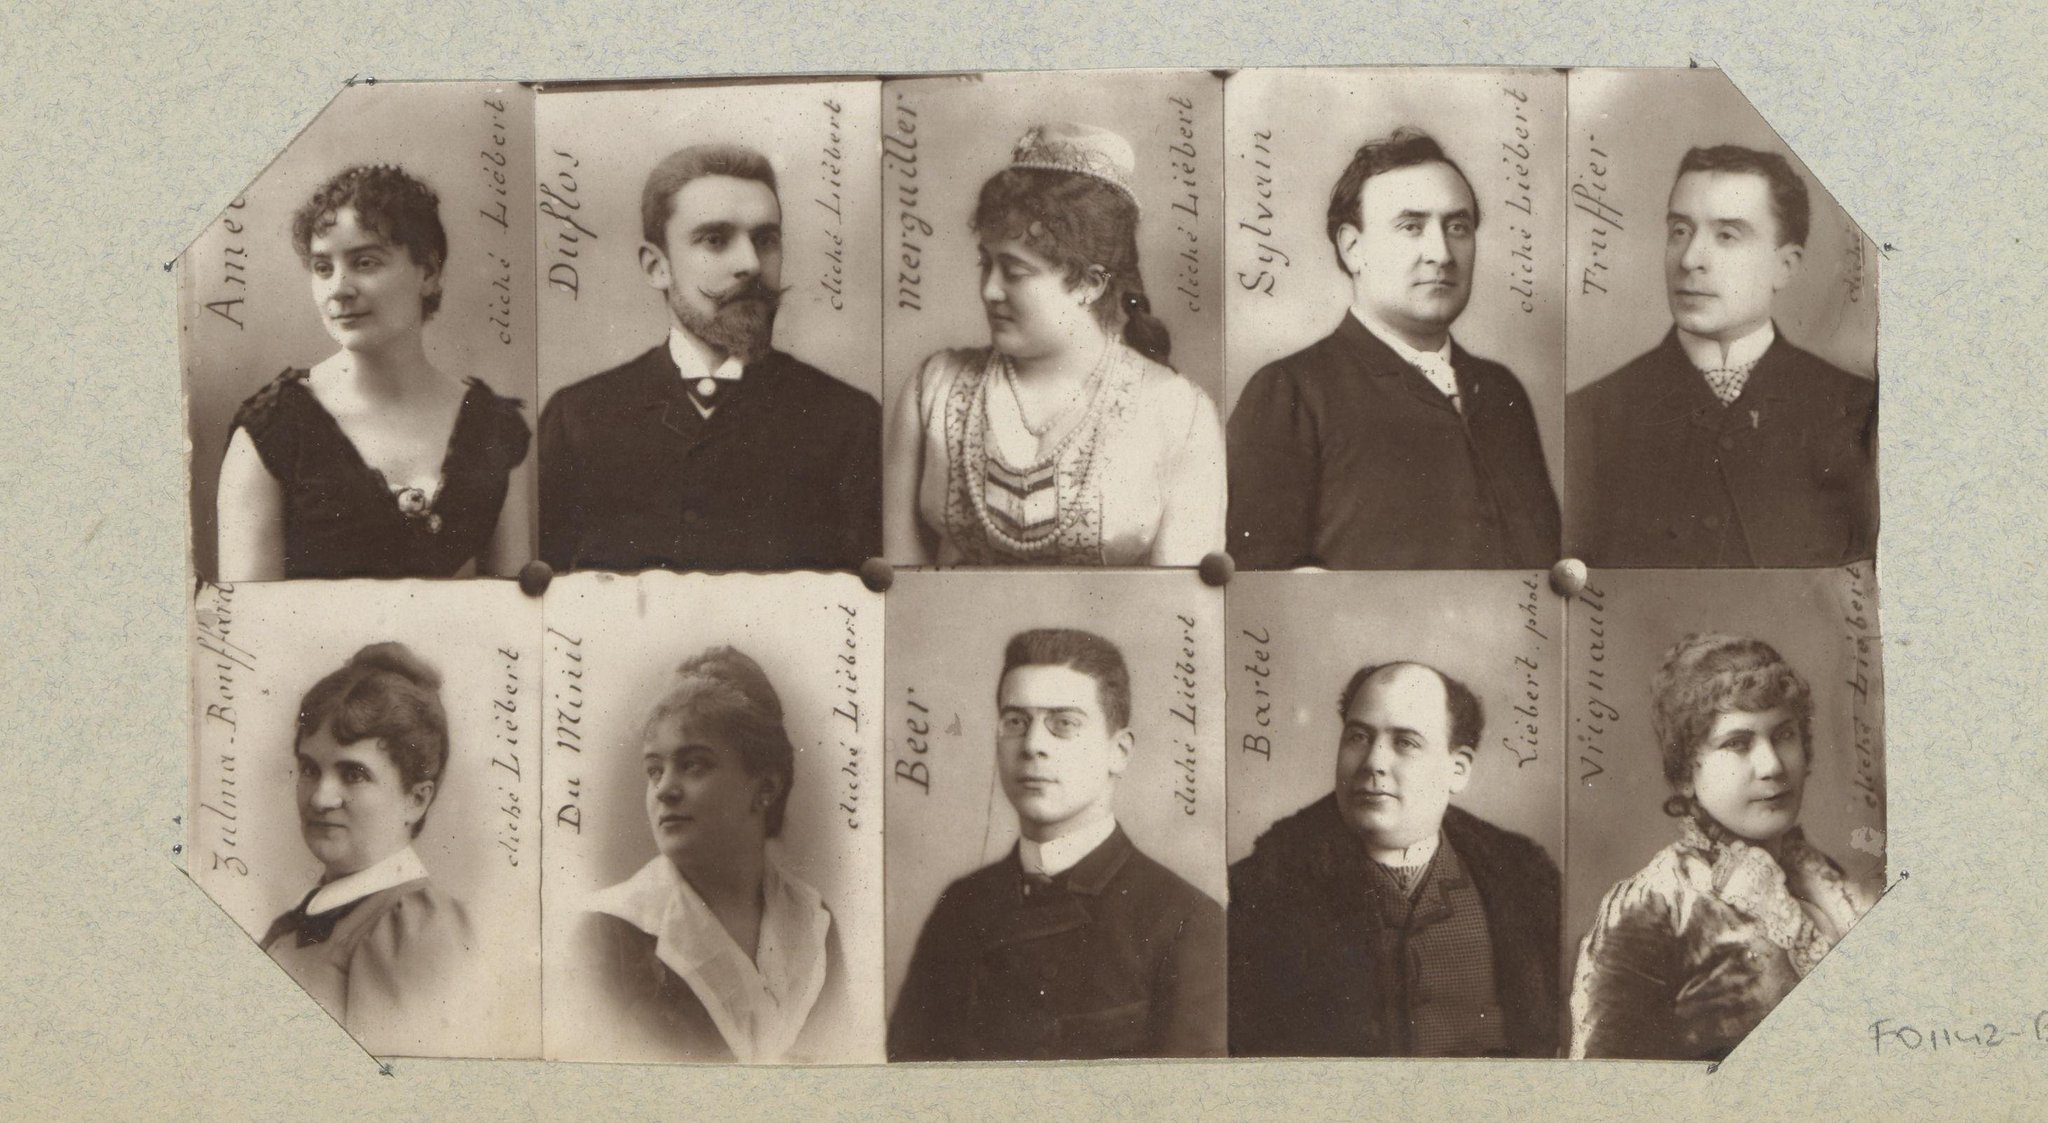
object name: photomontage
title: Tien portretten van zangers en acteurs: Amel, Duflos, Merguiller, Sylvain, Truffier, Zulma -Bouffard, Du Minil, Beer, Bartel en Vrignault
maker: alphonse-justin liébert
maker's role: fotograaf, marinier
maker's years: 1827-1914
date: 1880-1900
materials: paper, photographic support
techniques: carbon print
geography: europe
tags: portrait of actor, actress, opera-singer (female), opera-singer (male), europe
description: Onderdeel van Album van een Franse amateur met foto's van Frankrijk, Algerije, Palmyra, de Wereldtentoonstelling van 1900 en van bekende Fransen.